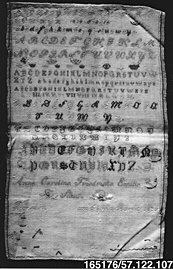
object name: sampler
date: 1826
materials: silk, wool